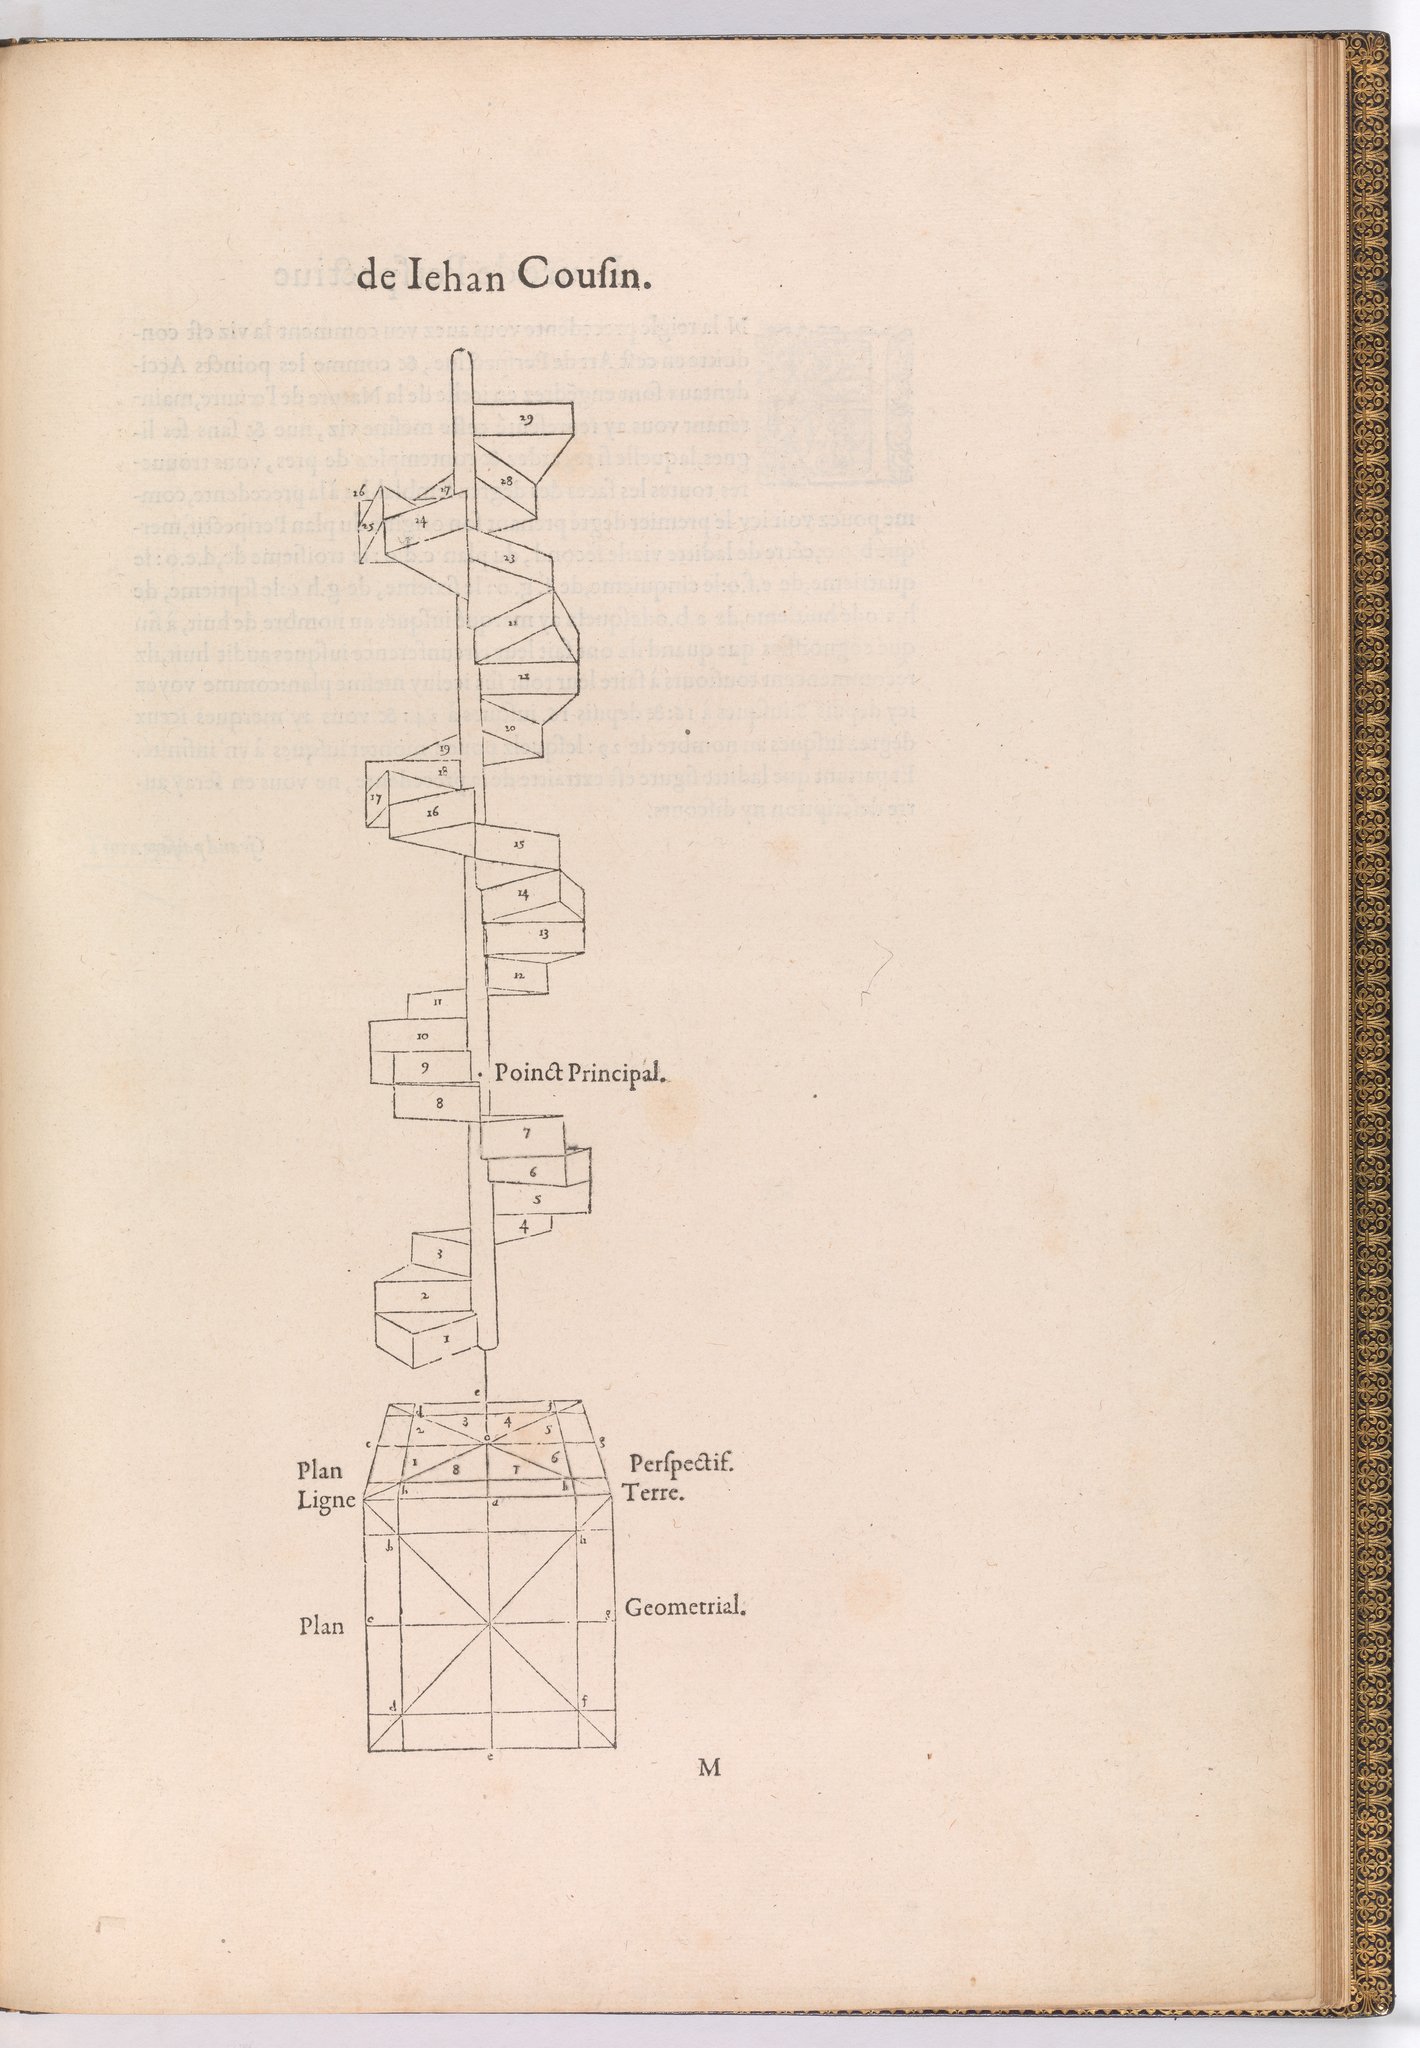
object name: book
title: Livre de Perspective de Jehan Cousin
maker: jean cousin the elder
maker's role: artist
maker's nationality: french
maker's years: 1485-1565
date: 1560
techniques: printing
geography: france